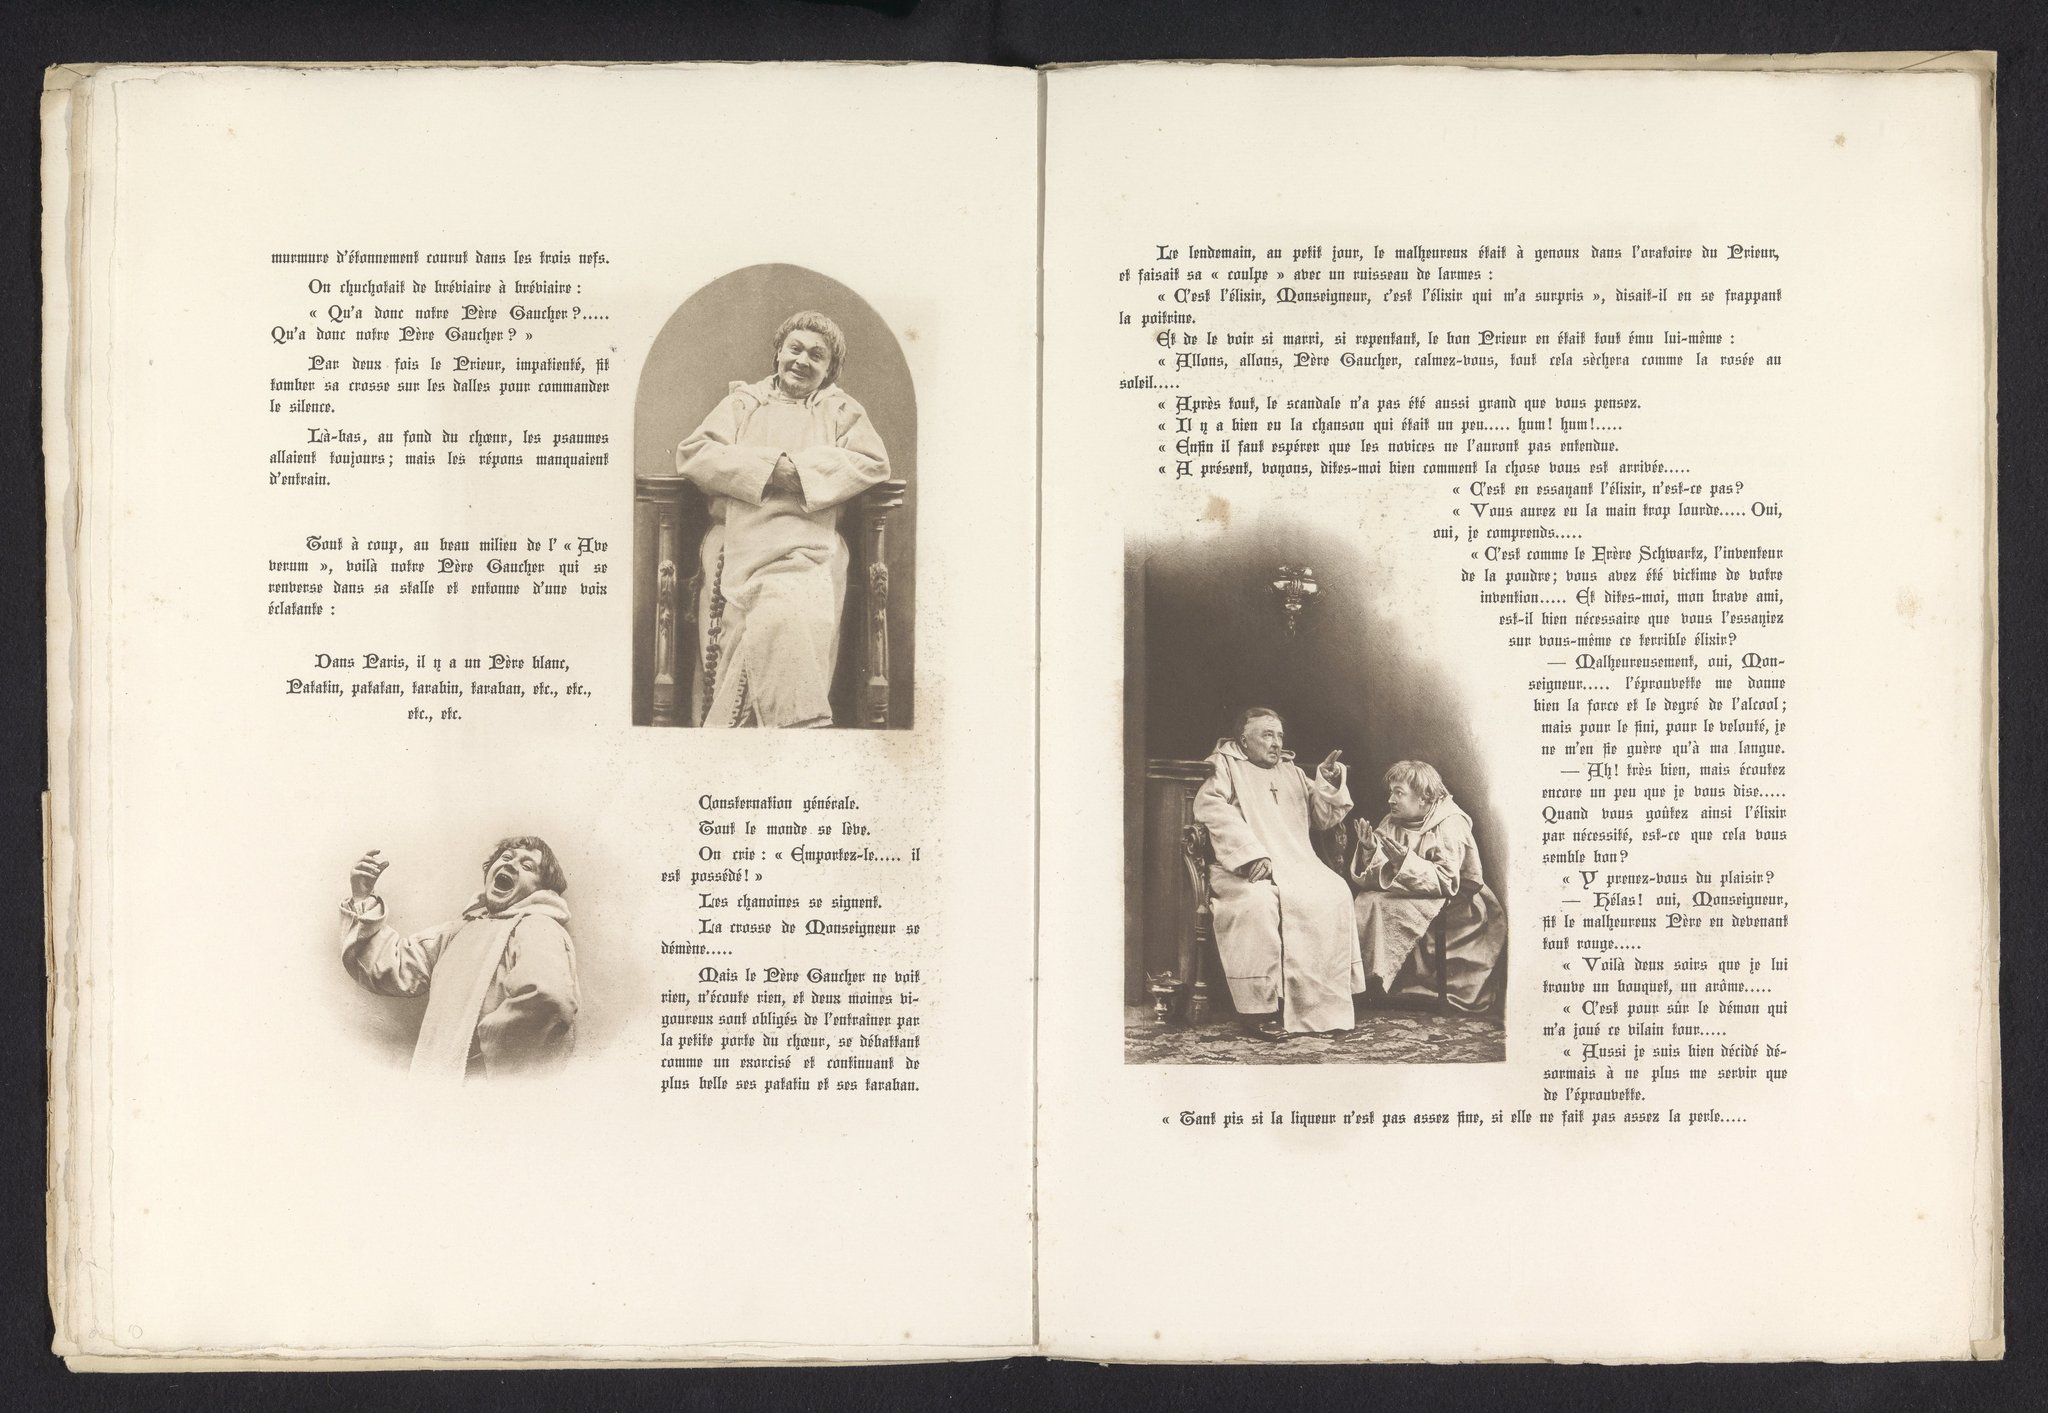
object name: photomechanical print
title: Twee afbeeldingen van een monnik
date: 1885-1896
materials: paper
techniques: photoaquatint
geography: france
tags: sitting figure, laughing, monk(s), friar(s)